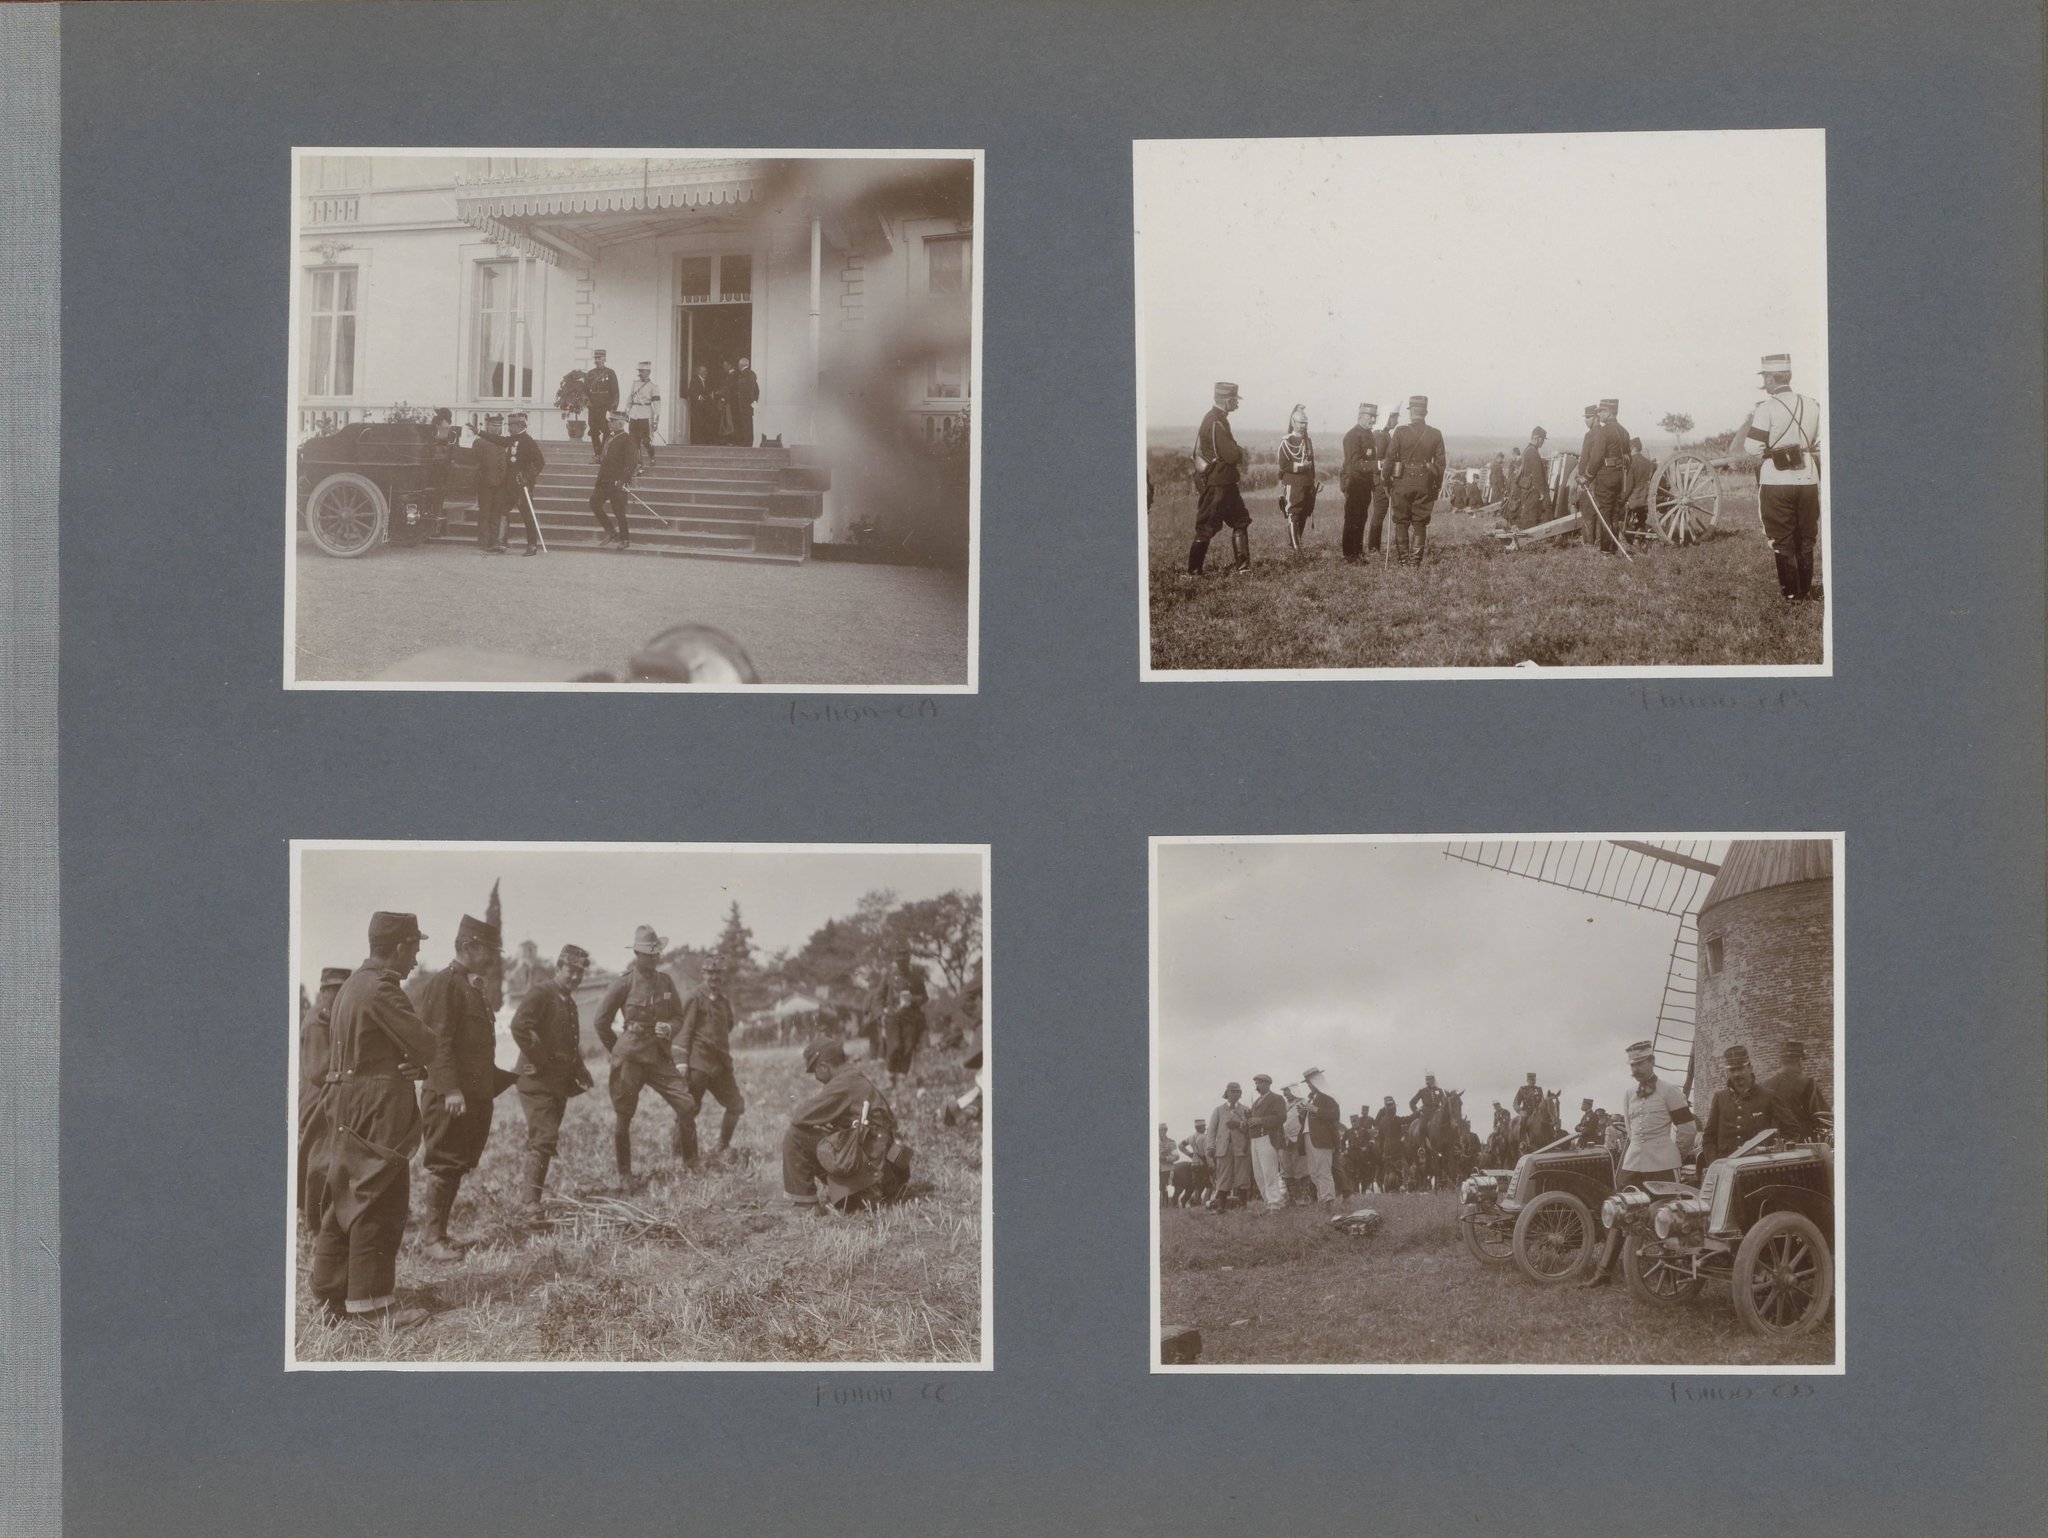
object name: photograph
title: Militairen verlaten een huis in Frankrijk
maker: Anonymous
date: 1902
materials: paper, photographic support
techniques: daylight paper print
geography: france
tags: commander-in-chief, general, marshal, land forces, departure ~ travelling, france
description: Onderdeel van Fotoalbum van een legeroefening in Zuidwest-Frankrijk in 1902.